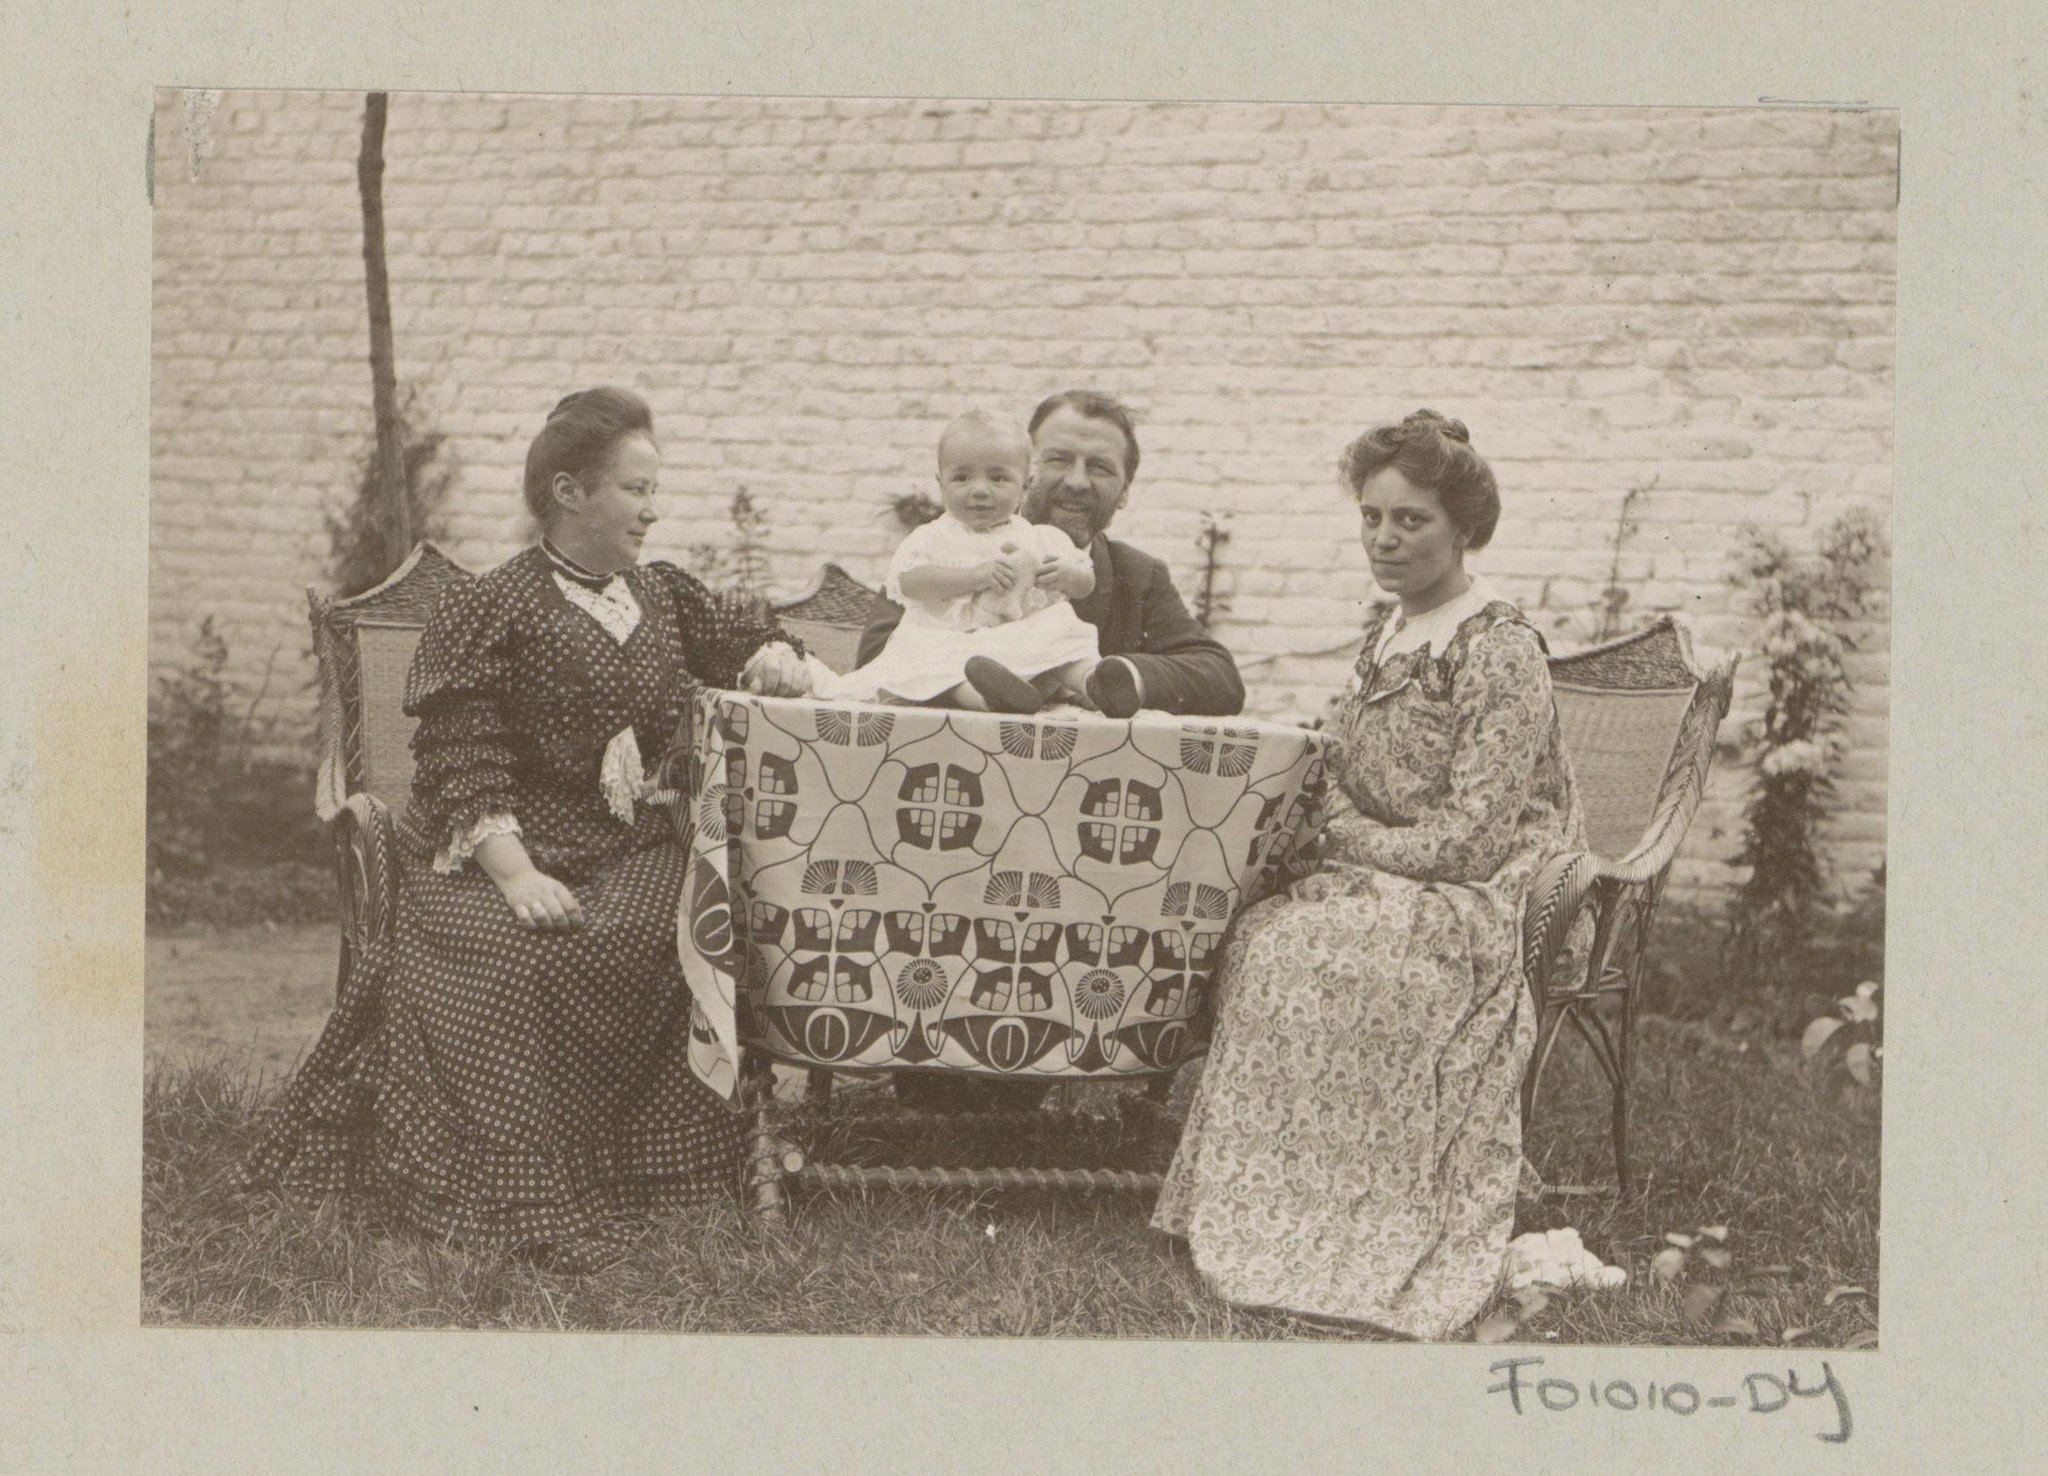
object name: photograph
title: Twee vrouwen, een man en een baby aan een tafel in een tuin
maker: Anonymous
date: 1900-1910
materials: photographic support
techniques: matte daylight collodion silver print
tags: parents with their children, garden, infant, baby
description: Onderdeel van Familiealbum met onder meer foto's van Wijnhandel Kraaij & Co. Bordeaux-Amsterdam.